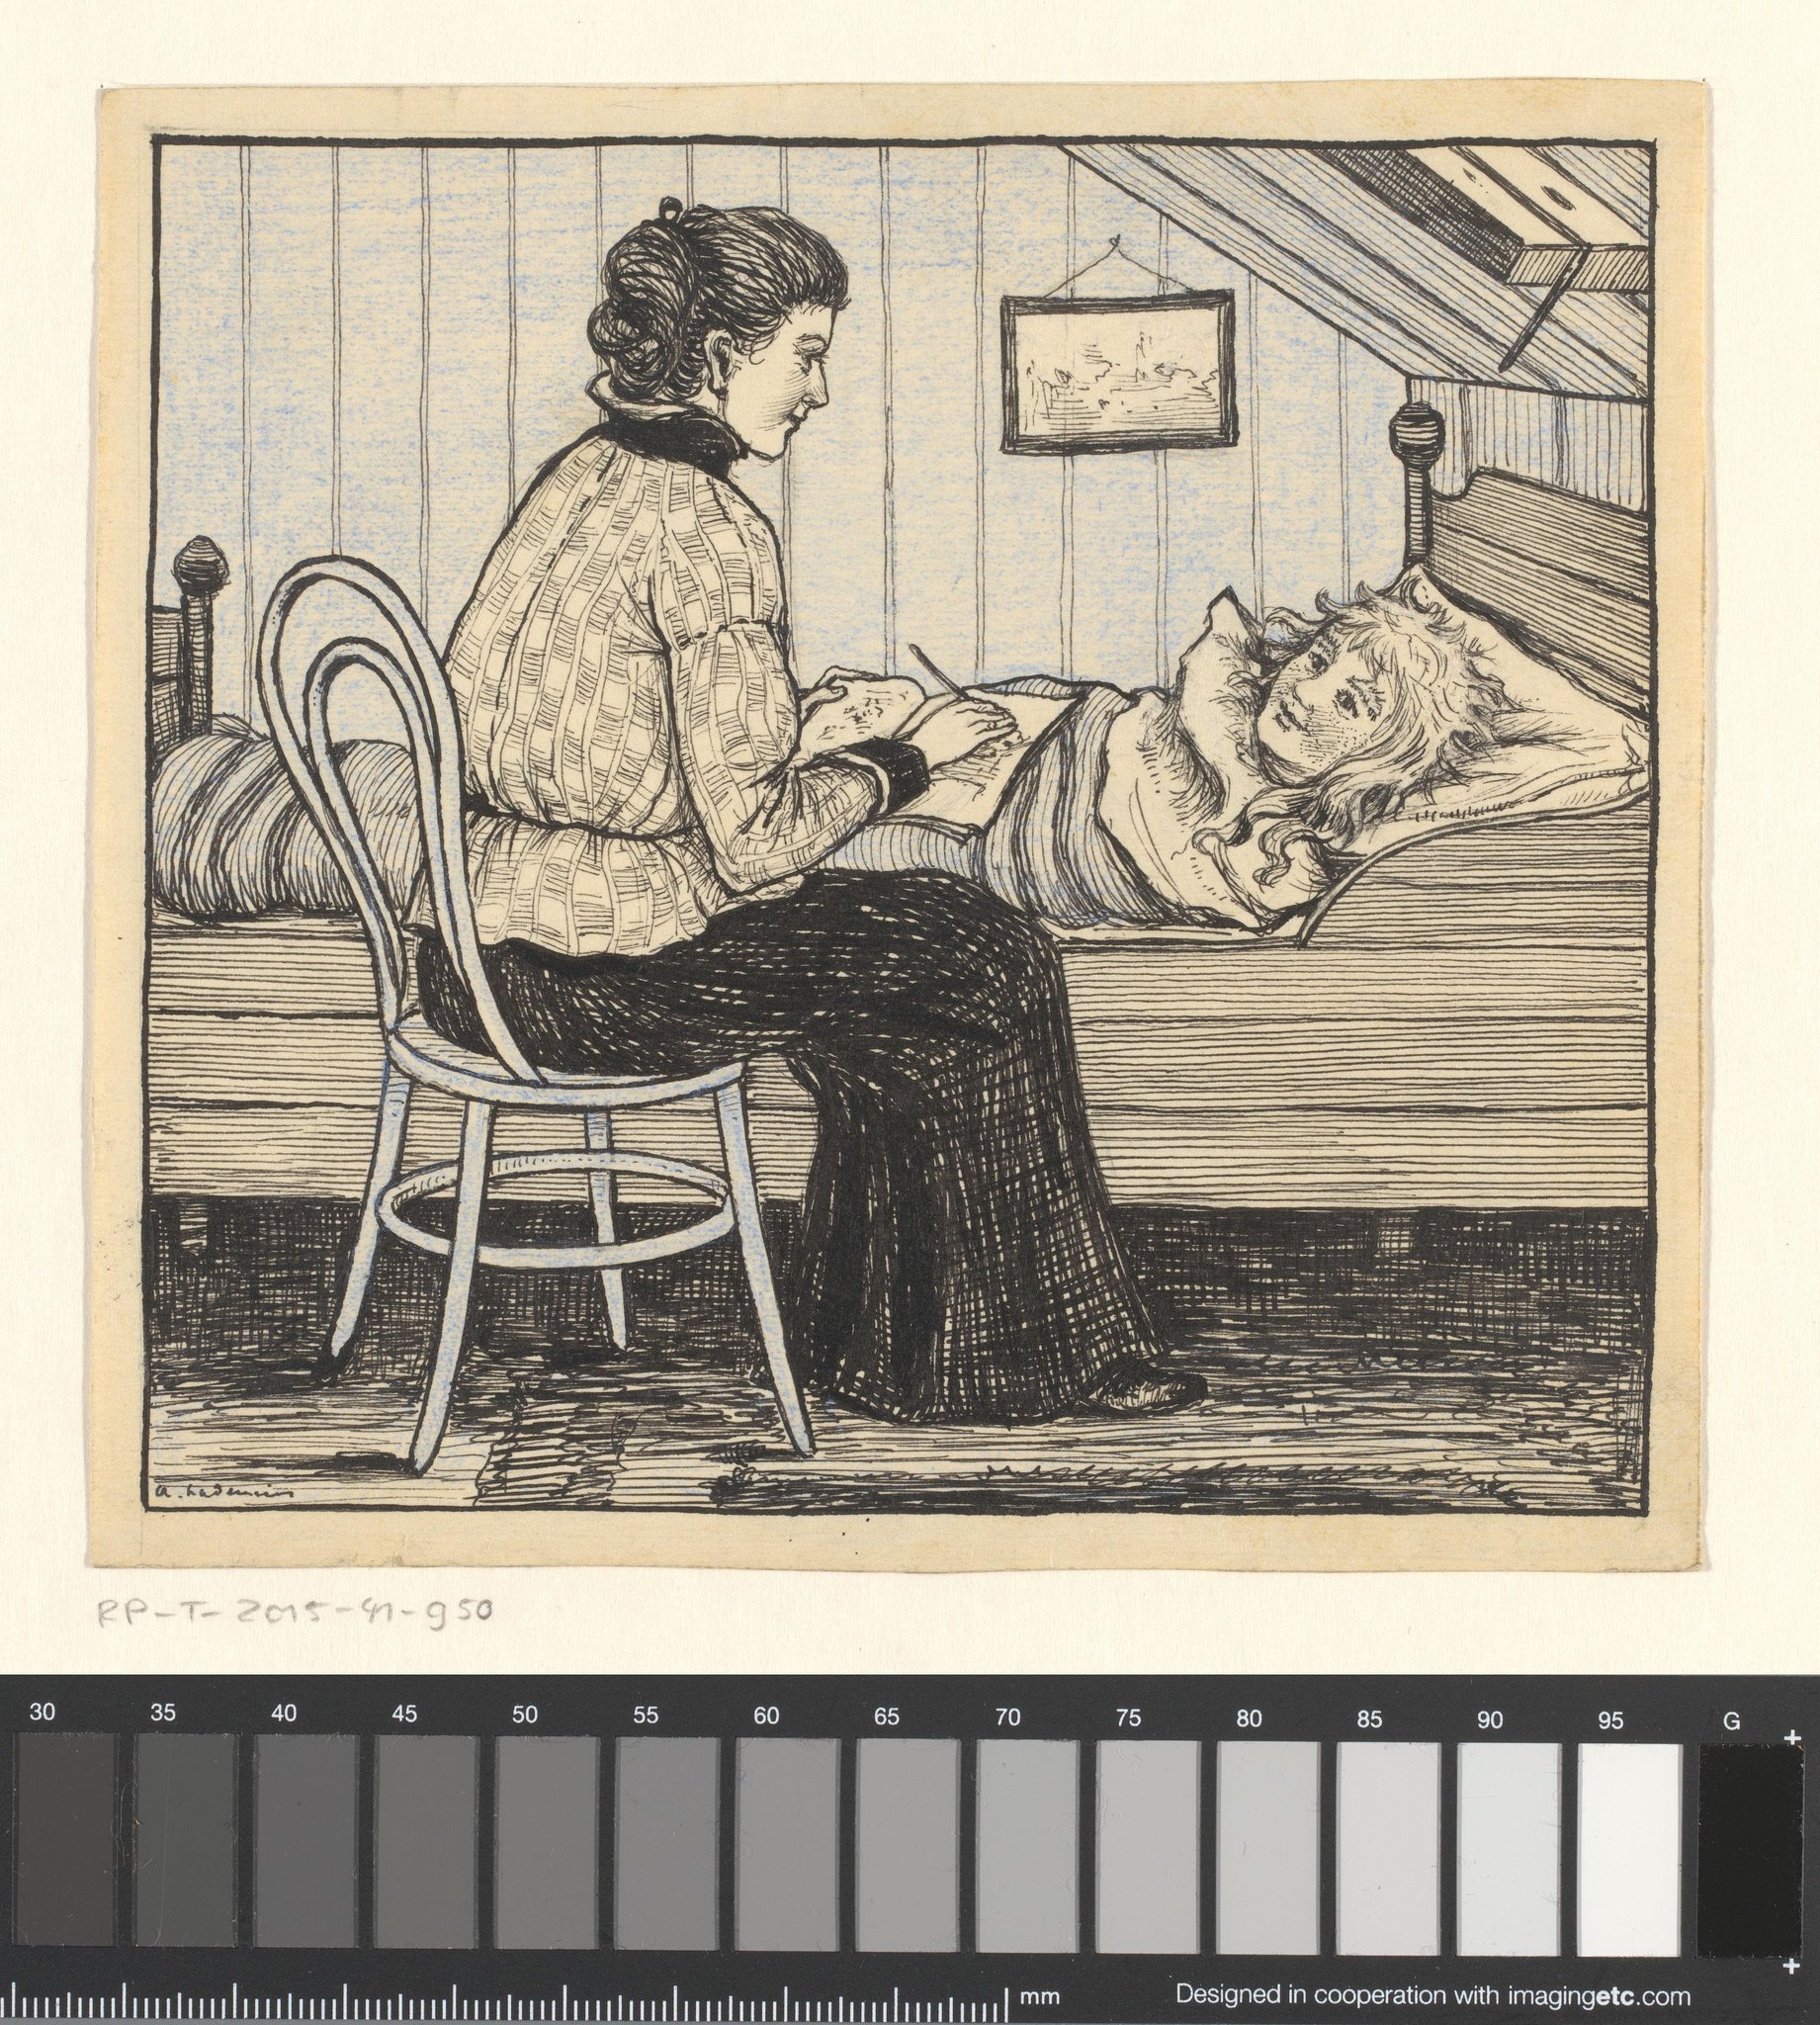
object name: boekillustratie ontwerp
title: Schrijvende vrouw aan een bed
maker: adri ladenius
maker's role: draughtsman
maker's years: 1883-1953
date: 1893-1953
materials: ink, paper, pencil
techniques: pen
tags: bed, materials to write on, writing surfaces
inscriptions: annotation: ‘Toen het vroor,/ dat het kraakte/ II’, signature: ‘A. Ladenius’, collector's mark: Lugt 2228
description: Een vrouw zit op een stoel met een notitieblok in de hand te schrijven naast een bed. In bed ligt een, mogelijk ziek, meisje met verwilderde haren.